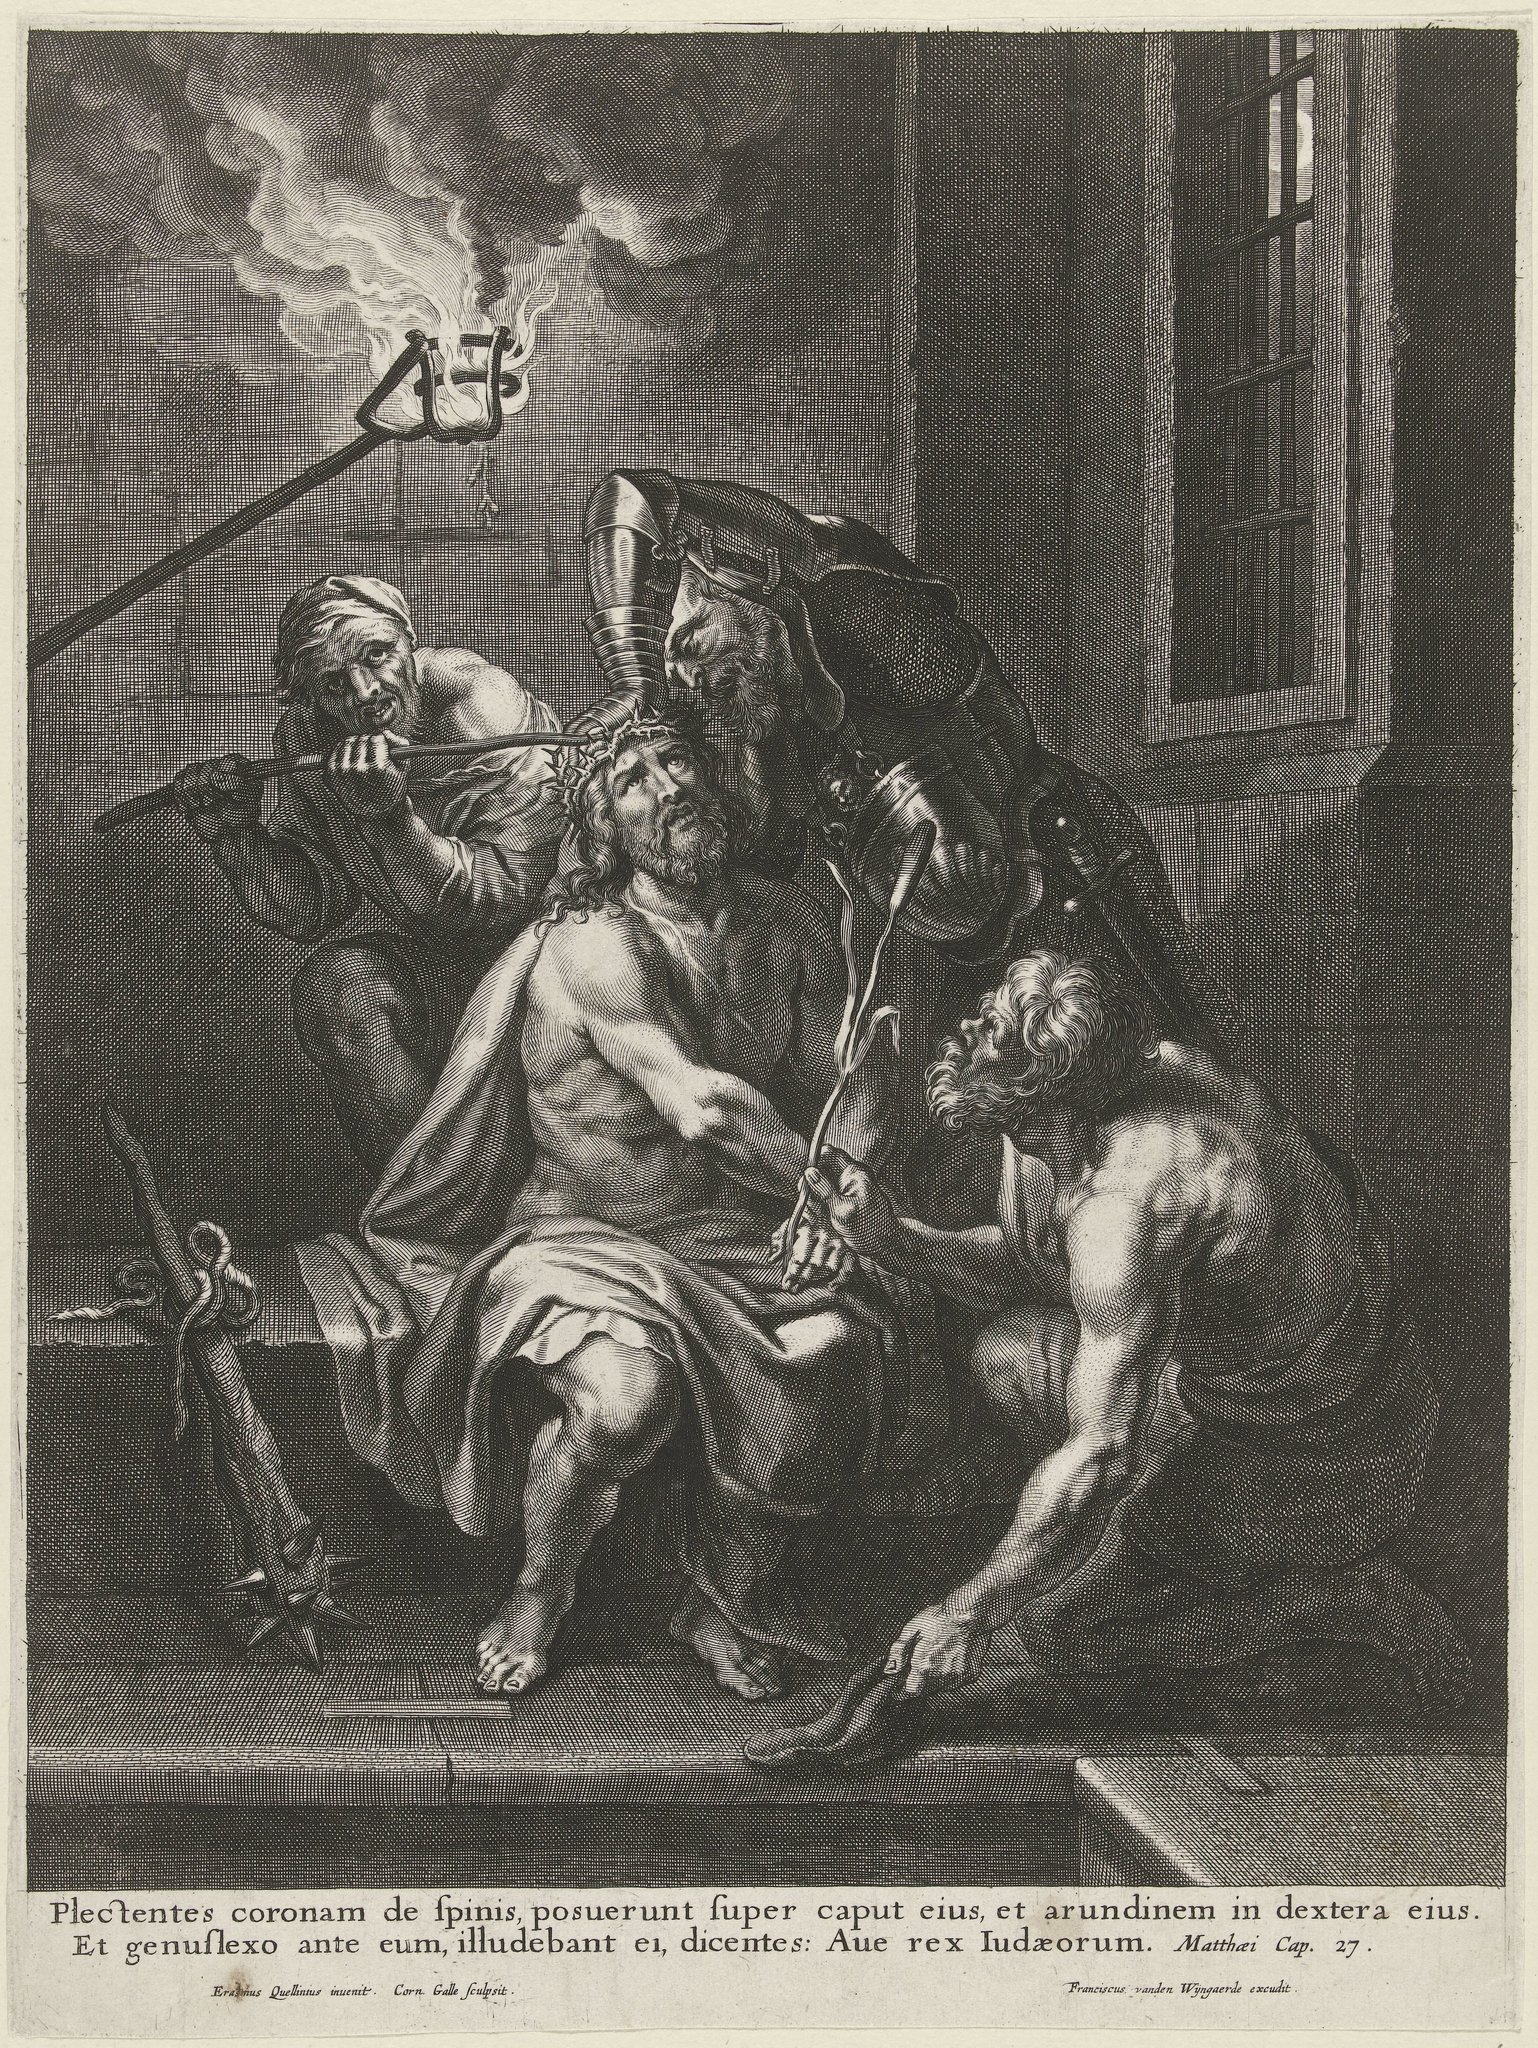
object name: print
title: De doornenkroning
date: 1610-1650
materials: paper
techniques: engraving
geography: antwerp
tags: the crowning with thorns: soldiers with sticks place a thorny crown on christ's head and give him a reed (matthew 27:27-31; mark 15:16-20; john 19:2-3)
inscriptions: collector's mark: Lugt 240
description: Christus zit in het gevangenis en twee beulen zetten hem de doornenkroon op. Een man in harnas drukt de kroon goed vast. Een andere man toont Christus een rietstengel. Onder de afbeelding een Latijnse bijbeltekst uit Math. 27.